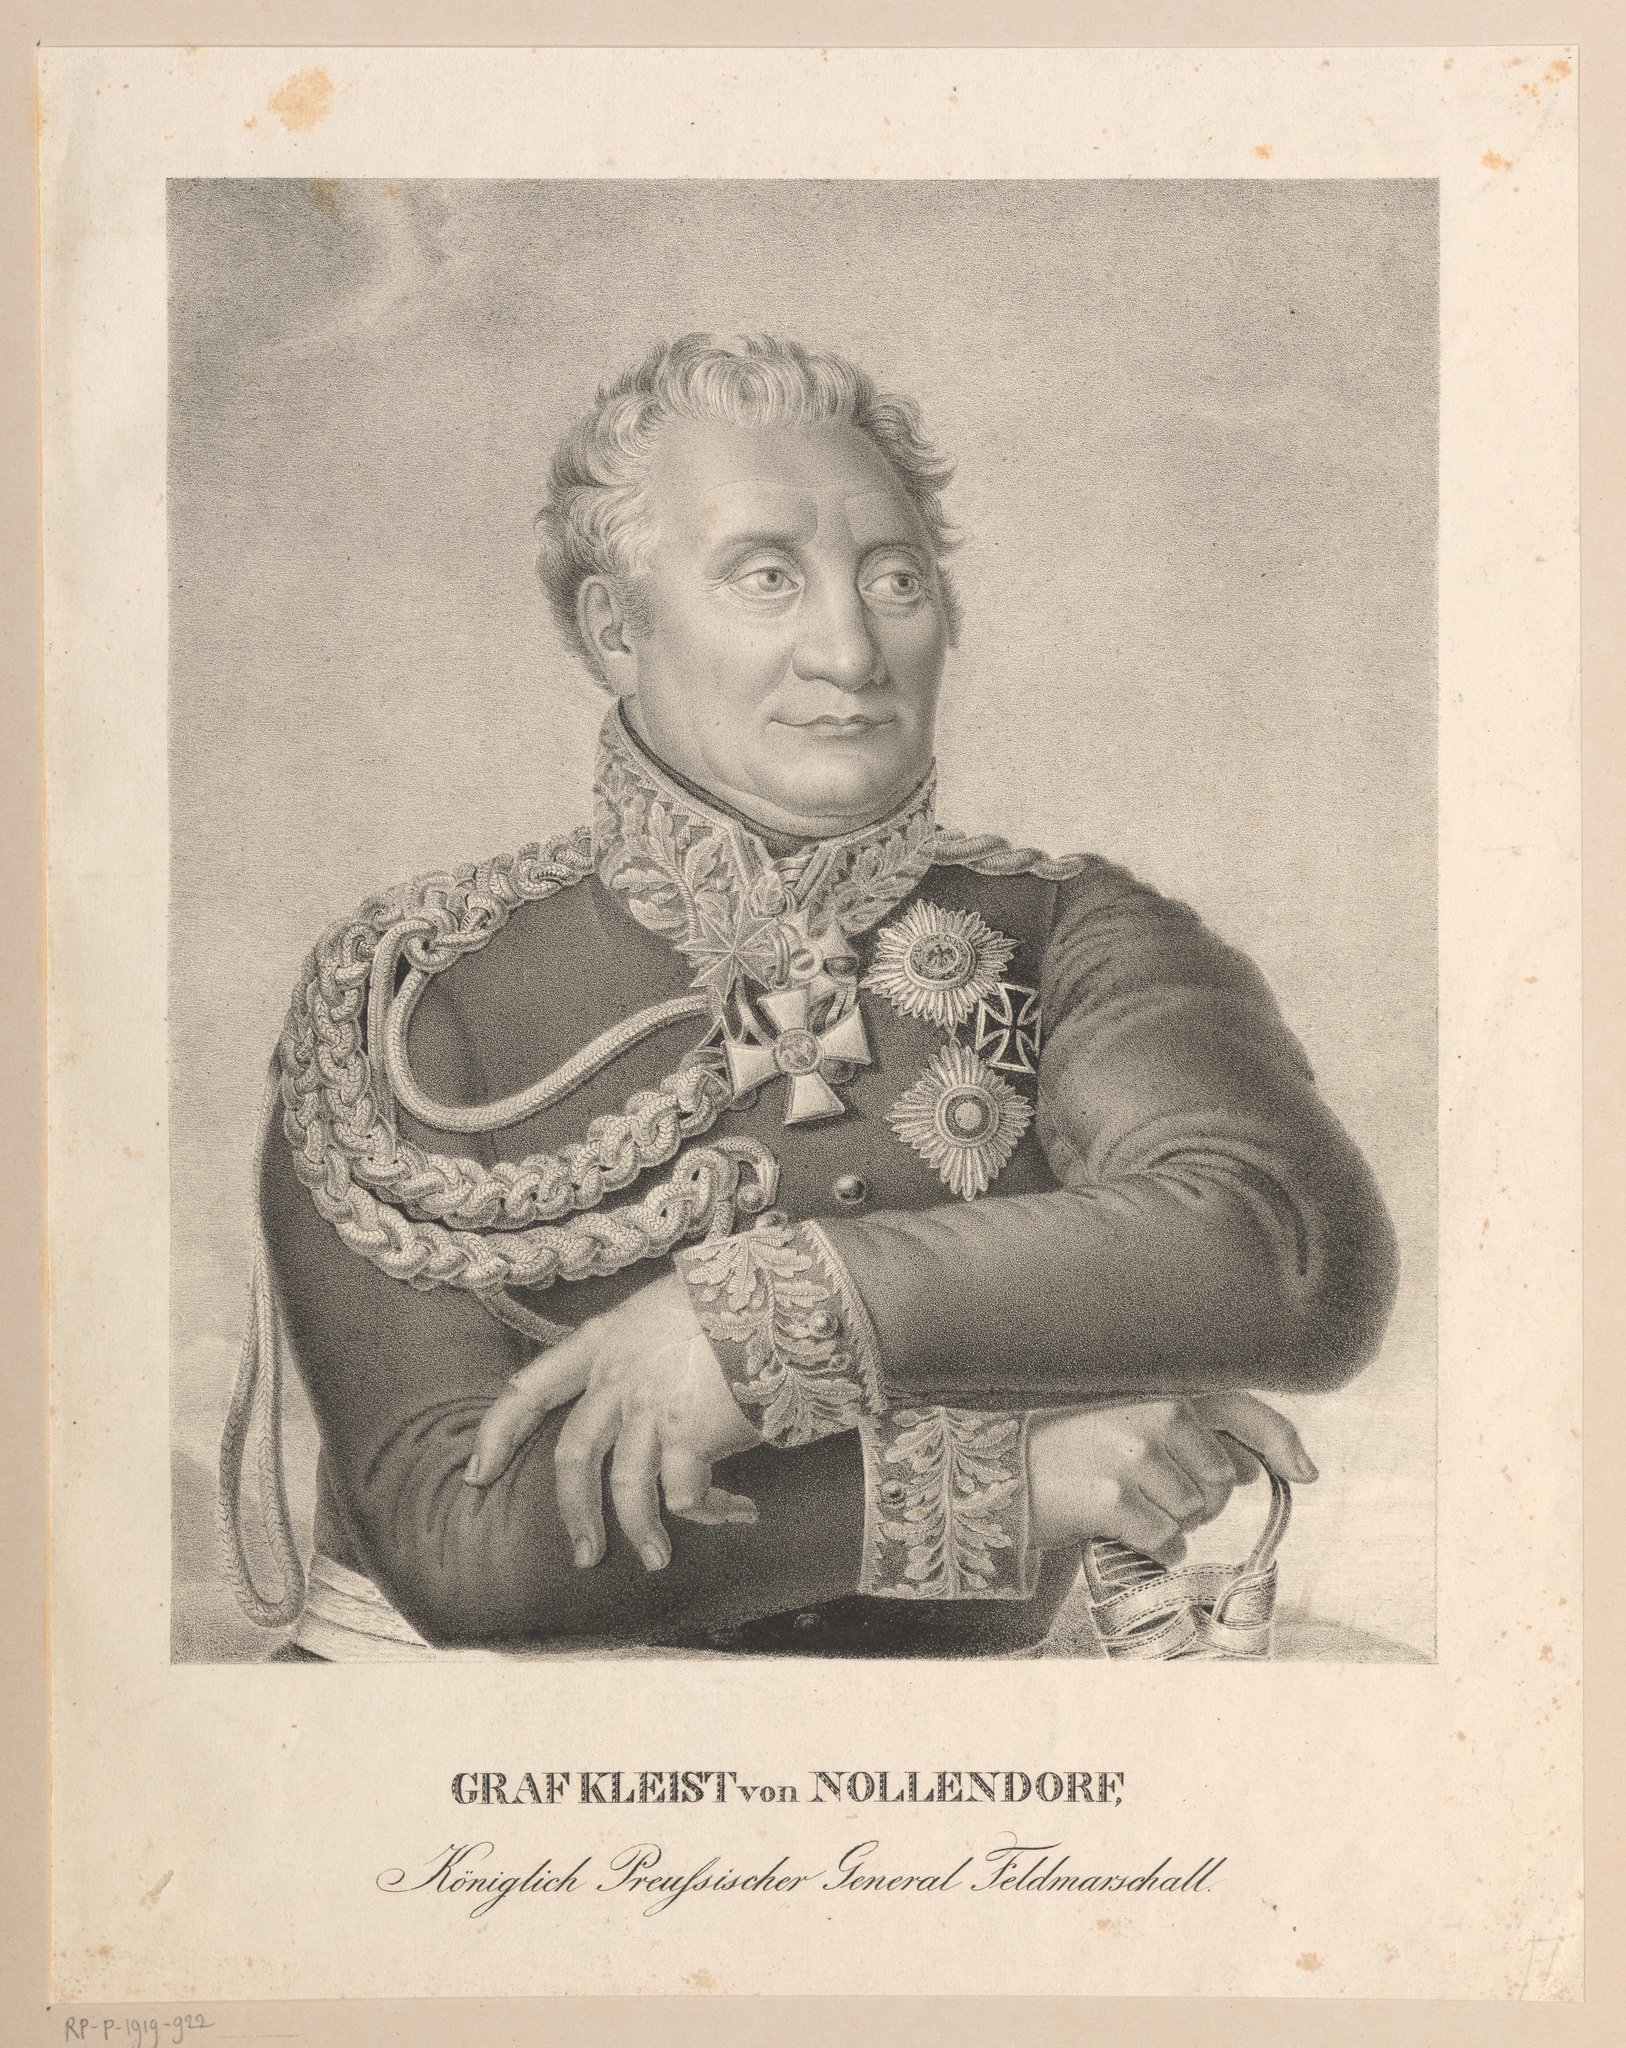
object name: print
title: Portret van Friedrich Heinrich Ferdinand Emil Kleist von Nollendorf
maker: Anonymous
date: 1792-1823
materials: paper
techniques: lithograph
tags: berlin, historical persons, medals and other marks of military honour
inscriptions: collector's mark: Lugt 2228